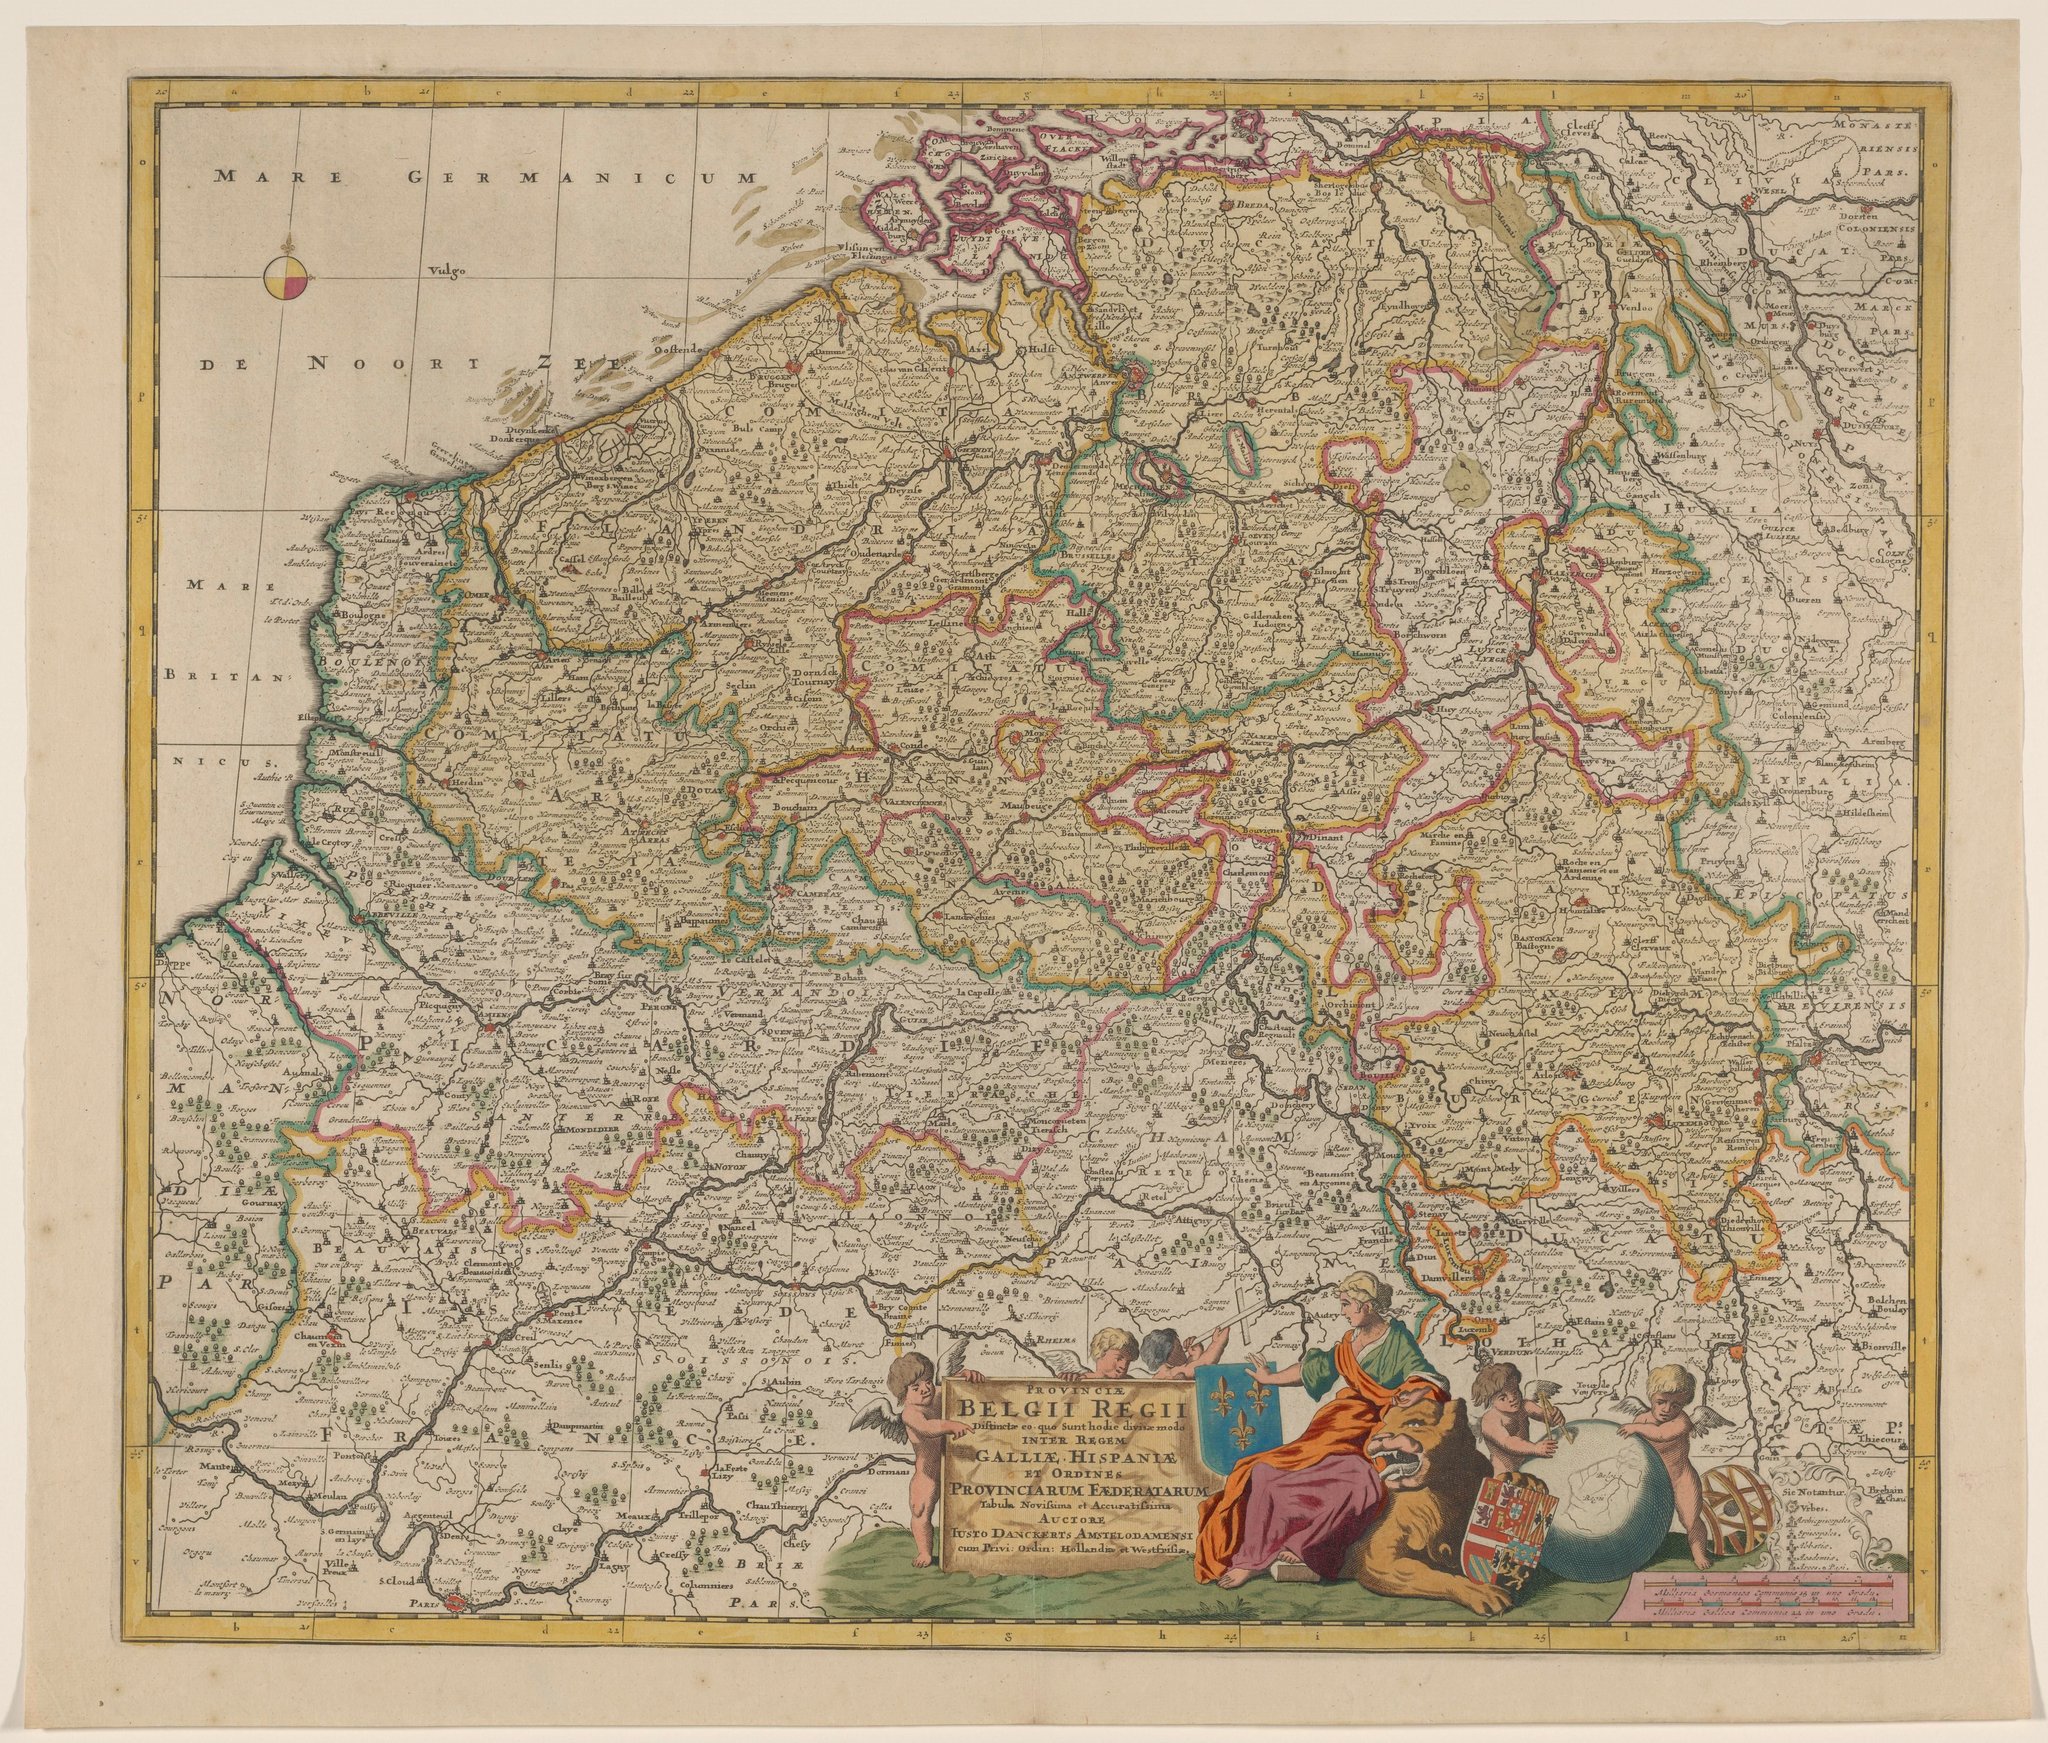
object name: print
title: Kaart van de Zuidelijke Nederlanden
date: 1684-1701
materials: paper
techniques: engraving, hand coloring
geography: amsterdam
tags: maps of separate countries or regions, beasts of prey, predatory animals: lion, armorial bearing, heraldry, southern netherlands, belgium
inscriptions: collector's mark: Lugt 2228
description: Kaart van de Zuidelijke Nederlanden. Onder, in het midden, de titelcartouche. Daaromheen een voorstelling met putti met meetkundige instrumenten, een vrouw, leeuw en de wapens van het Koninkrijk Frankrijk en de koning van Spanje. Rechtsonder een cartouche met legenda en een ander cartouche met twee schaalstokken: 8 Milliaria Germanica Communia 15 in uno Gradu / 12 Milliaria Gallica Communia 24 in uno Gradu. De kaart is voorzien van een zoekrooster en een gradenverdeling langs de randen.